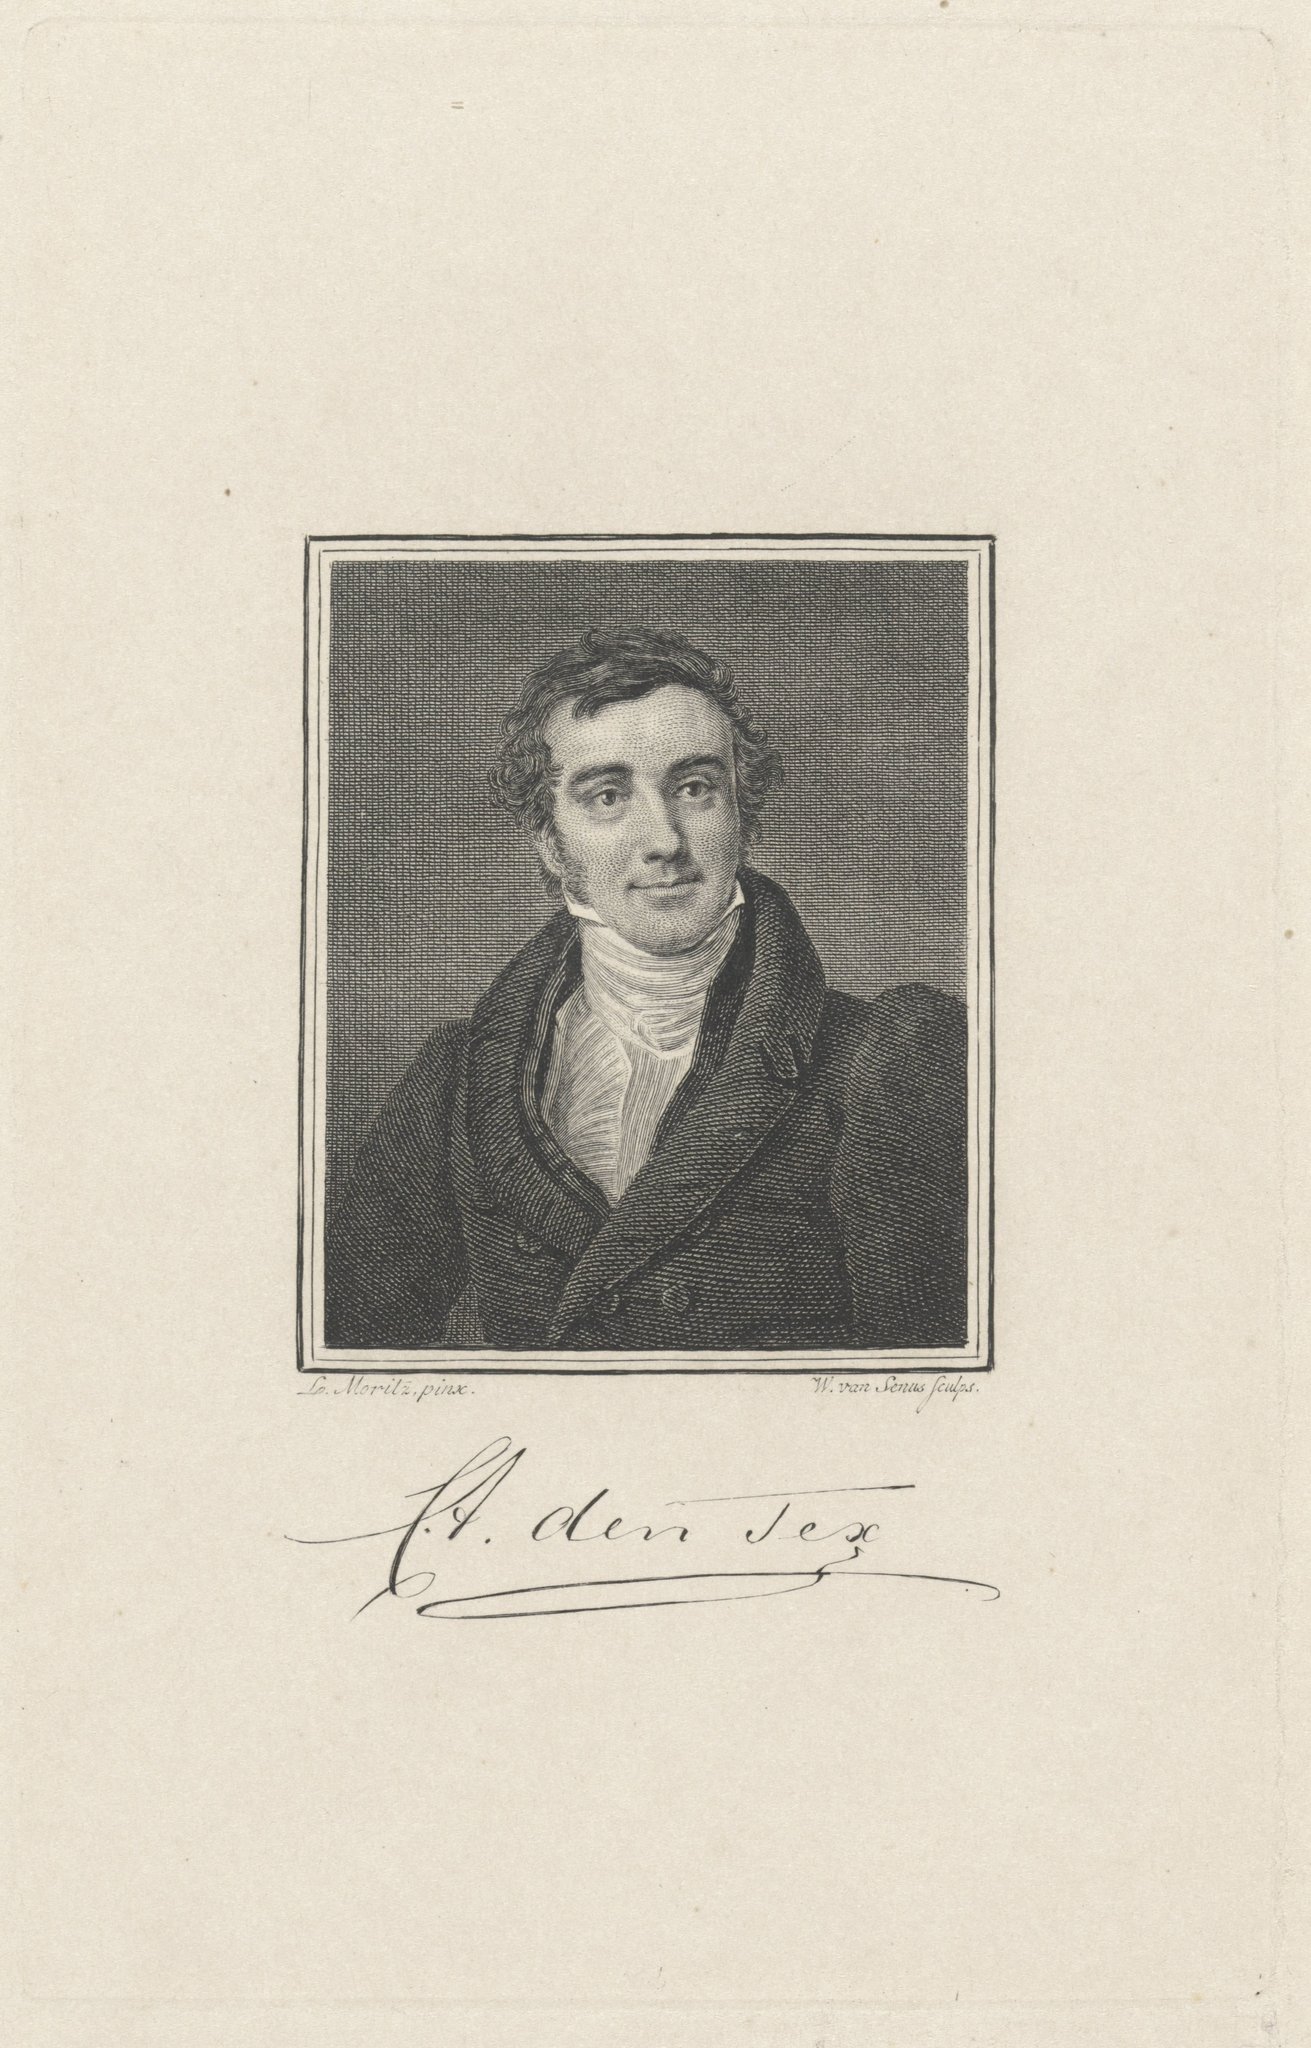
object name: print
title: Portret van Cornelis Anne den Tex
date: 1840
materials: paper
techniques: engraving, etching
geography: netherlands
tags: amsterdam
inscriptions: collector's mark: Lugt 2228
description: Portret van de Amsterdamse hoogleraar Cornelis Anne den Tex.